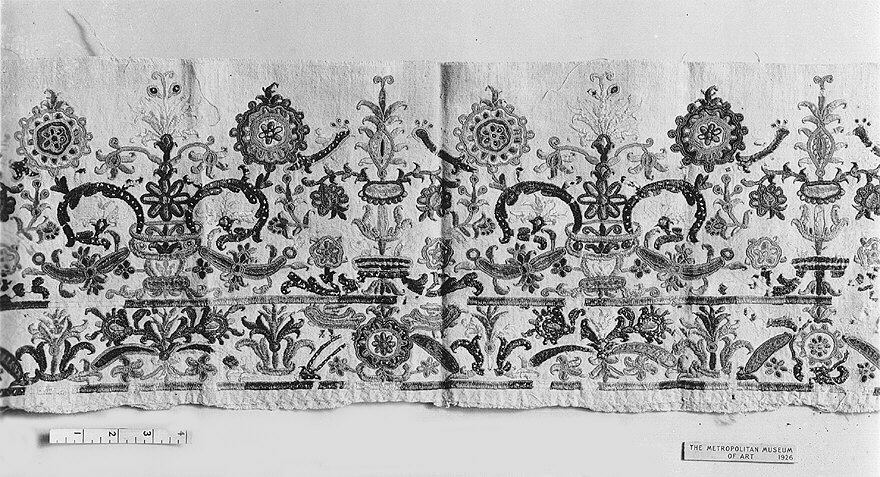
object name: border fragment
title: Portion of a dress border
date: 1701-1800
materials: linen, silk